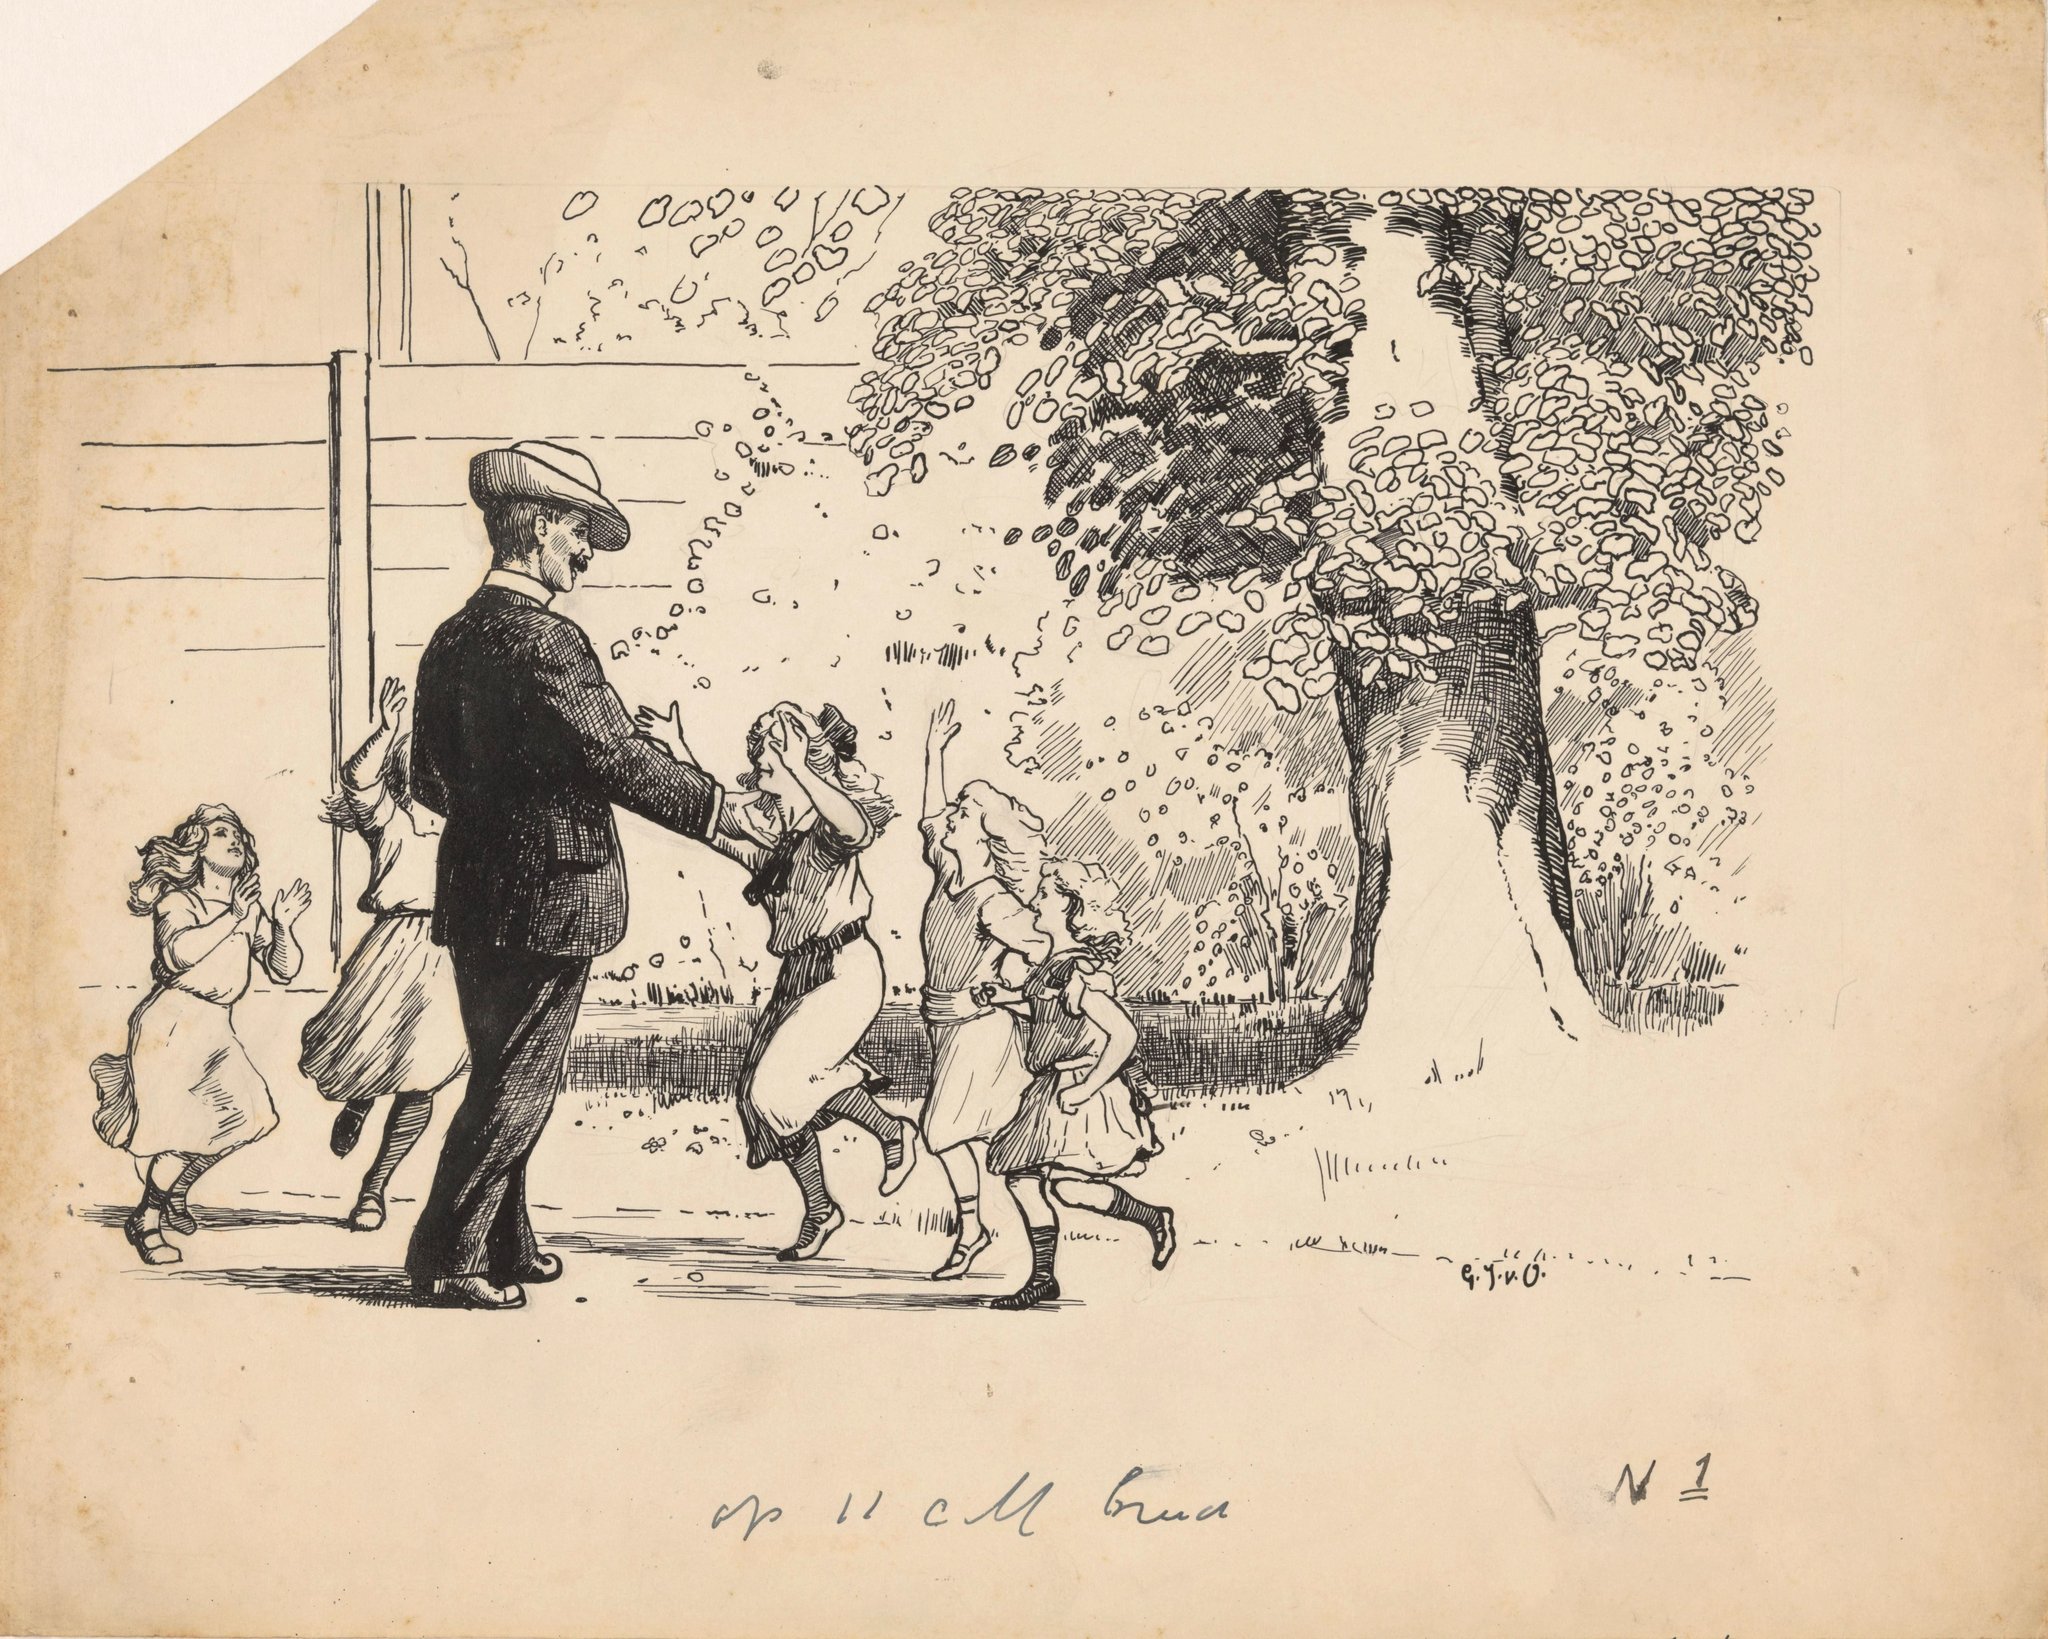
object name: boekillustratie ontwerp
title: Vijf meisjes begroeten een man met hoed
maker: gijsbertus johannes van overbeek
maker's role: draughtsman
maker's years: 1882-1947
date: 1892-1947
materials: ink, paper, pencil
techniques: pen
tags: trees, head-gear: hat (+ men's clothes), saluting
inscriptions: collector's mark: Lugt 2228, :, signature: ‘G.J.v.O.’, number: ‘N 1’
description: In een tuin rennen vijf meisjes enthousiast in de richting van een man met hoed.